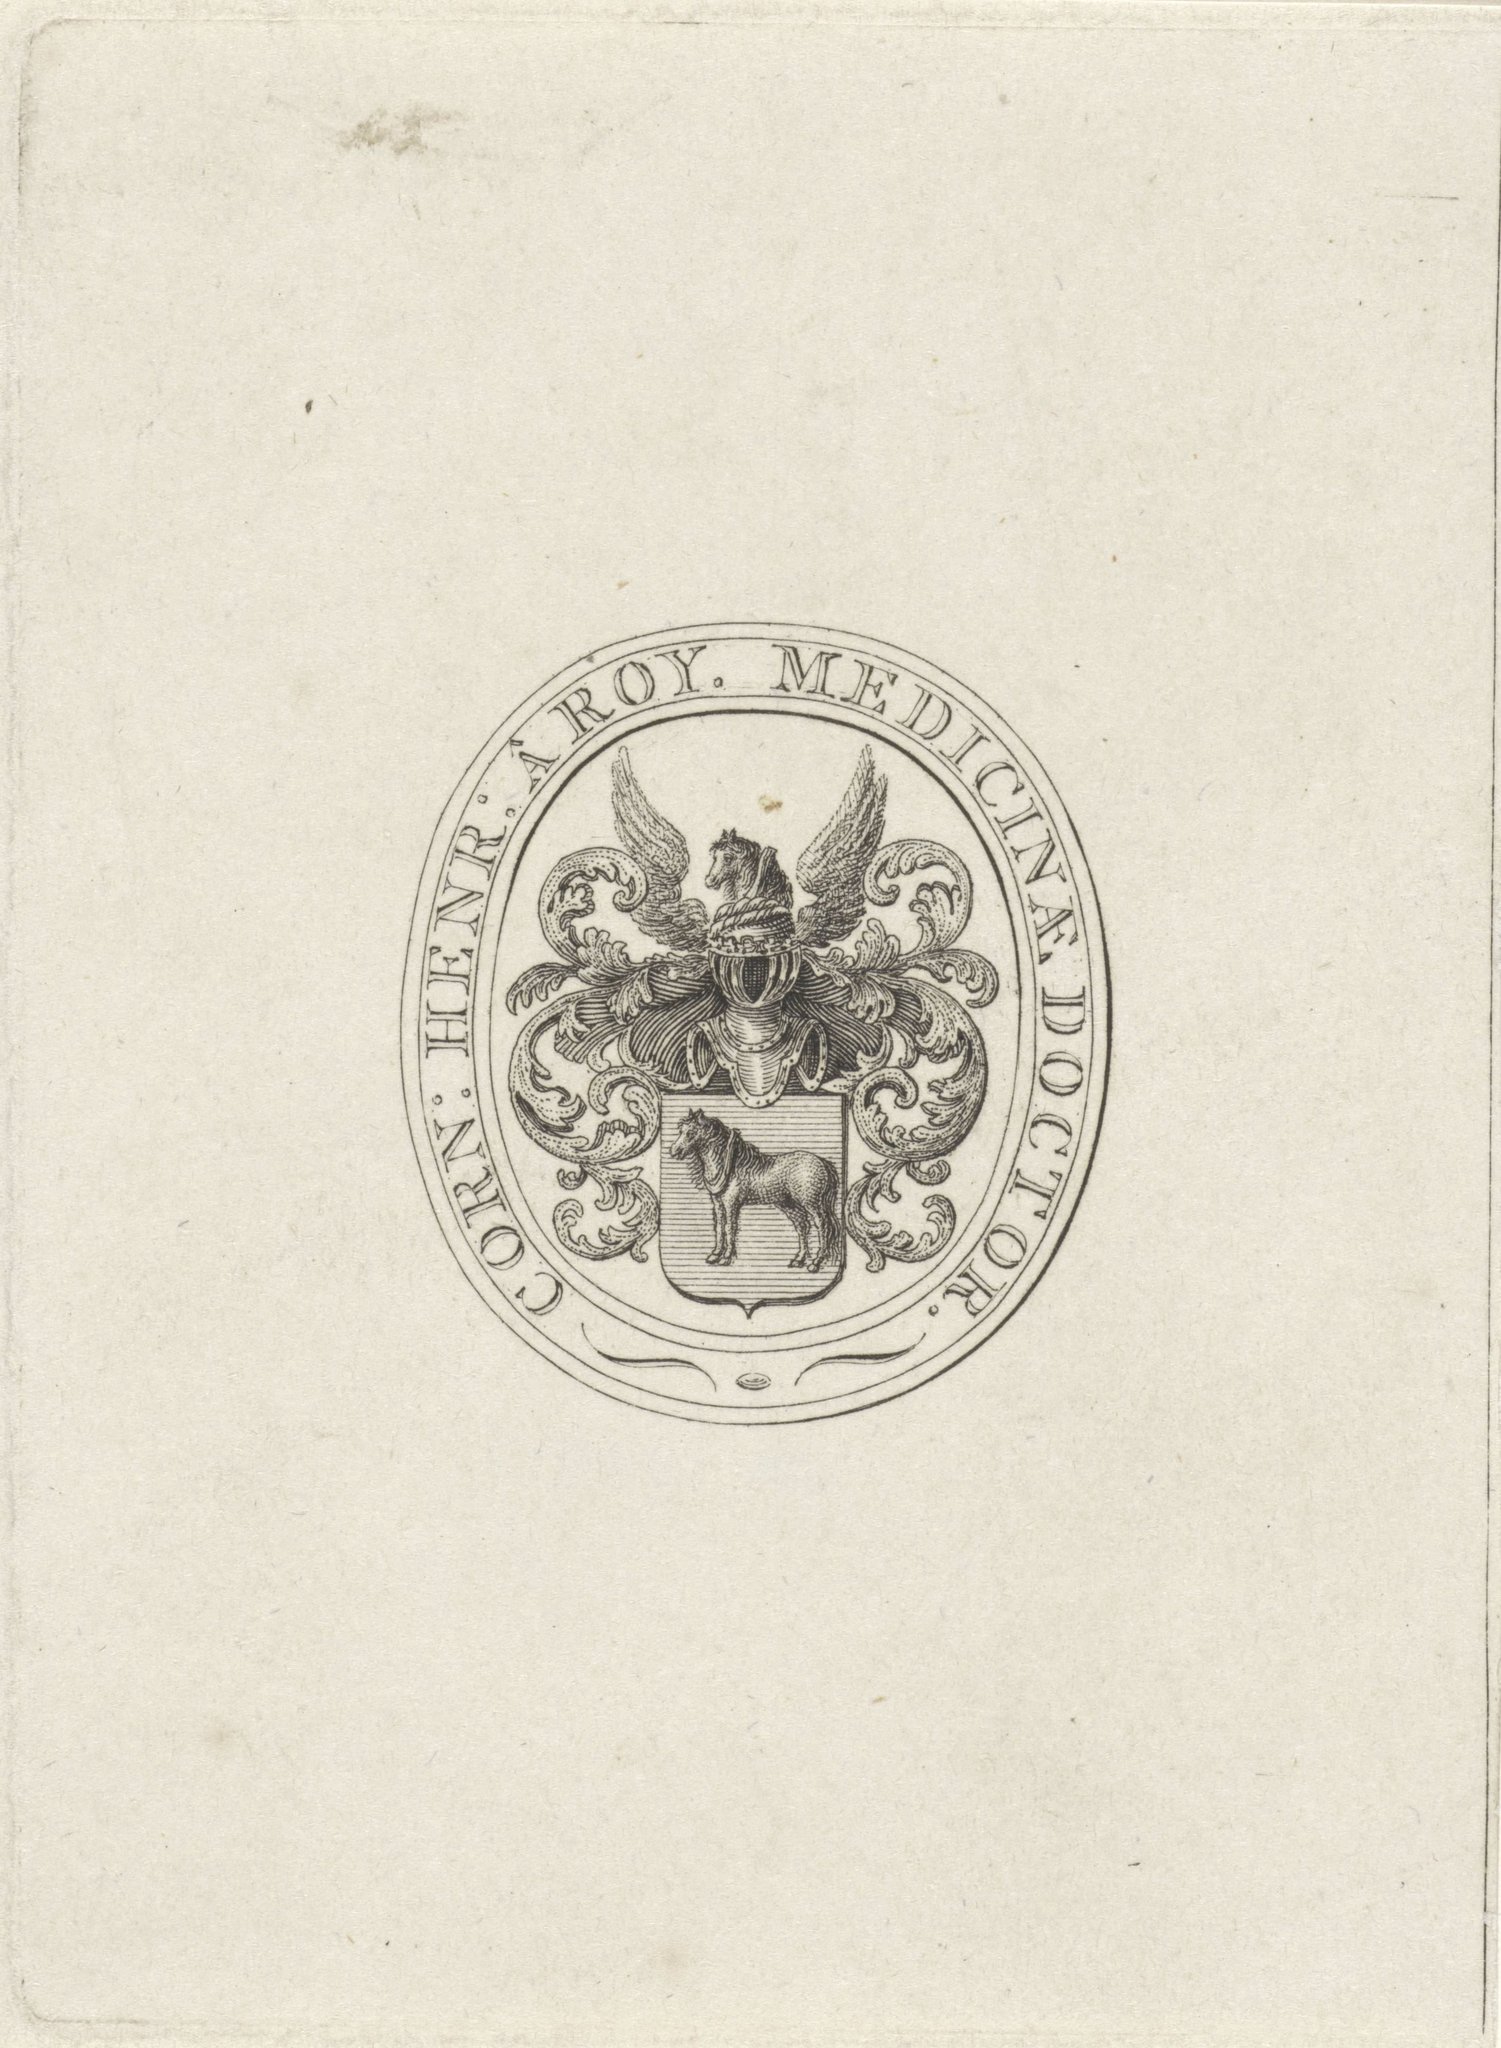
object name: print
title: Wapen van Cornelius Henricus à Roy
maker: reinier vinkeles (i)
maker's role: draughtsman, print maker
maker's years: 1741-1816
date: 1800-1816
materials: paper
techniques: etching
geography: amsterdam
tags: haarlem, armorial bearing, heraldry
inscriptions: collector's mark: Lugt 2228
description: Wapen van Cornelius Henricus à Roy, lijfarts van koning Lodewijk Napoleon.